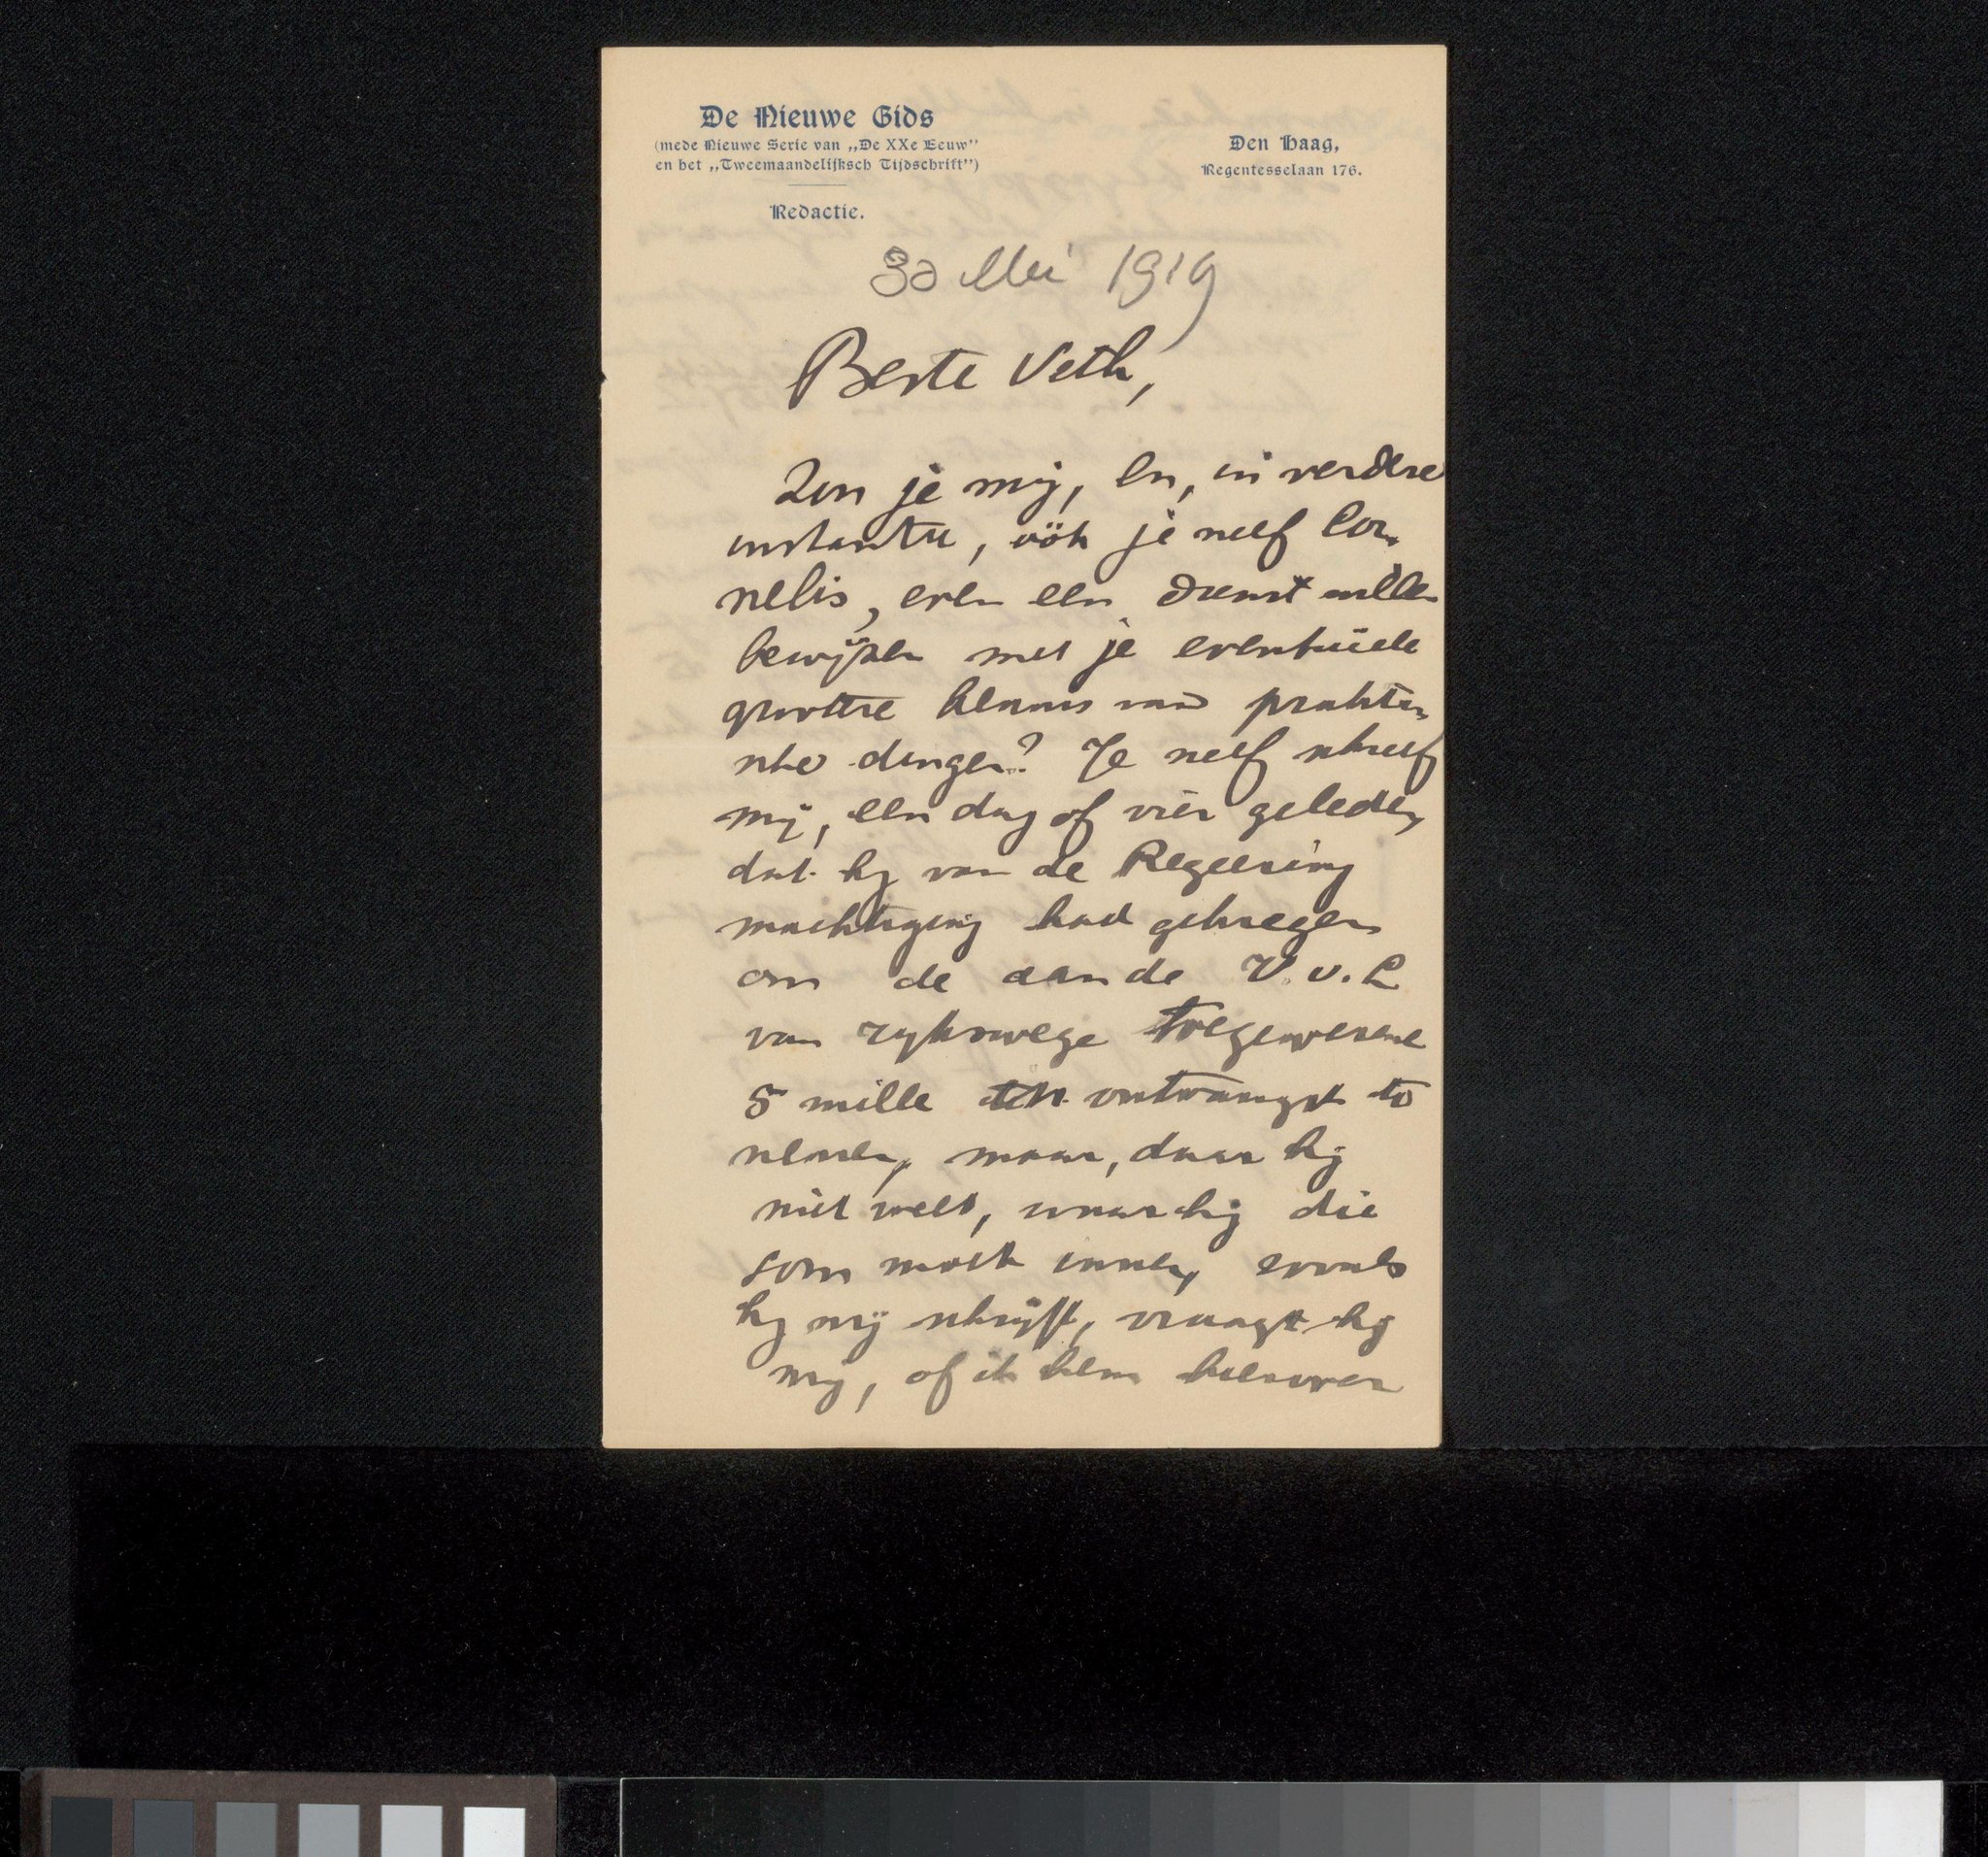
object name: letter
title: Brief aan Jan Veth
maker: willem kloos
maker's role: dichter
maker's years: 1859-1938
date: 1885-1925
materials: ink, paper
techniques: pen, printing, writing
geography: the hague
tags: painter, print maker, jan veth, amsterdam, draughtsman, françoise henri jacques mijnssen, money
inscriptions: collector's mark: ‘RPK’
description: Brief gedateerd 30 mei 1919 in latere hand.